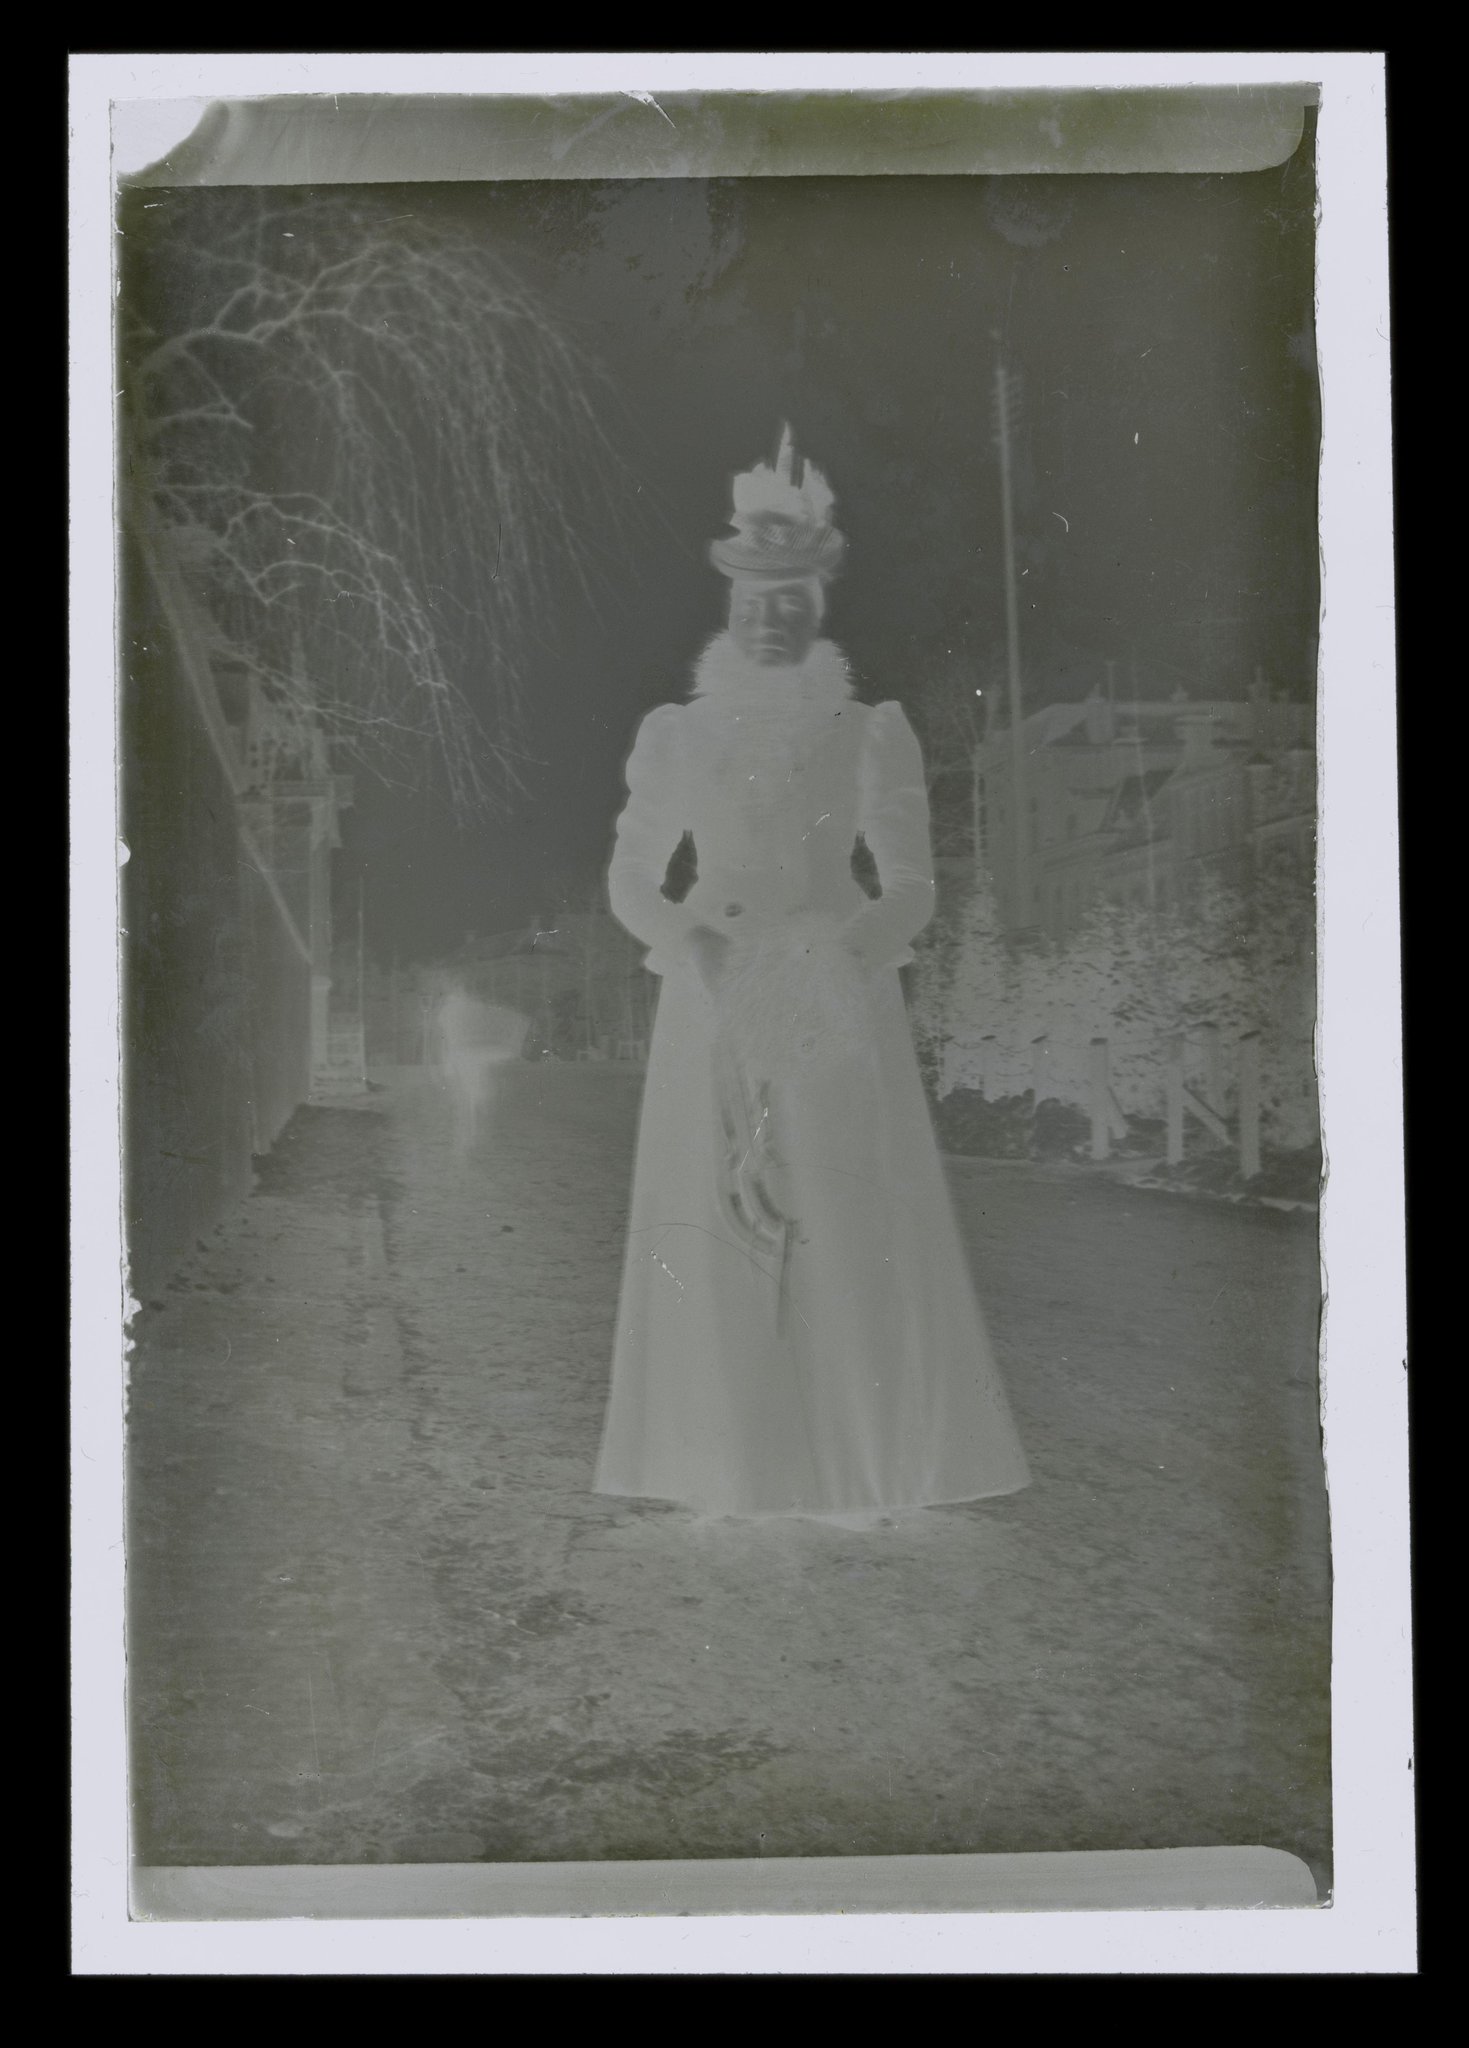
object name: glasnegatief, glasplaatnegatief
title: Portret van een onbekende vrouw op straat met hoed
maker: laurens lodewijk kleijn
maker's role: draughtsman, painter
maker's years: 1826-1909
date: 1865-1900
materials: glass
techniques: collodion process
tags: head-gear: hat, street, anonymous historical person portrayed - bb - woman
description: Onderdeel van groep glasnegatieven uit de nalatenschap van de schilder Laurens Lodewijk Kleijn, stillevens, portretten, zelfportretten en kunstreproducties.